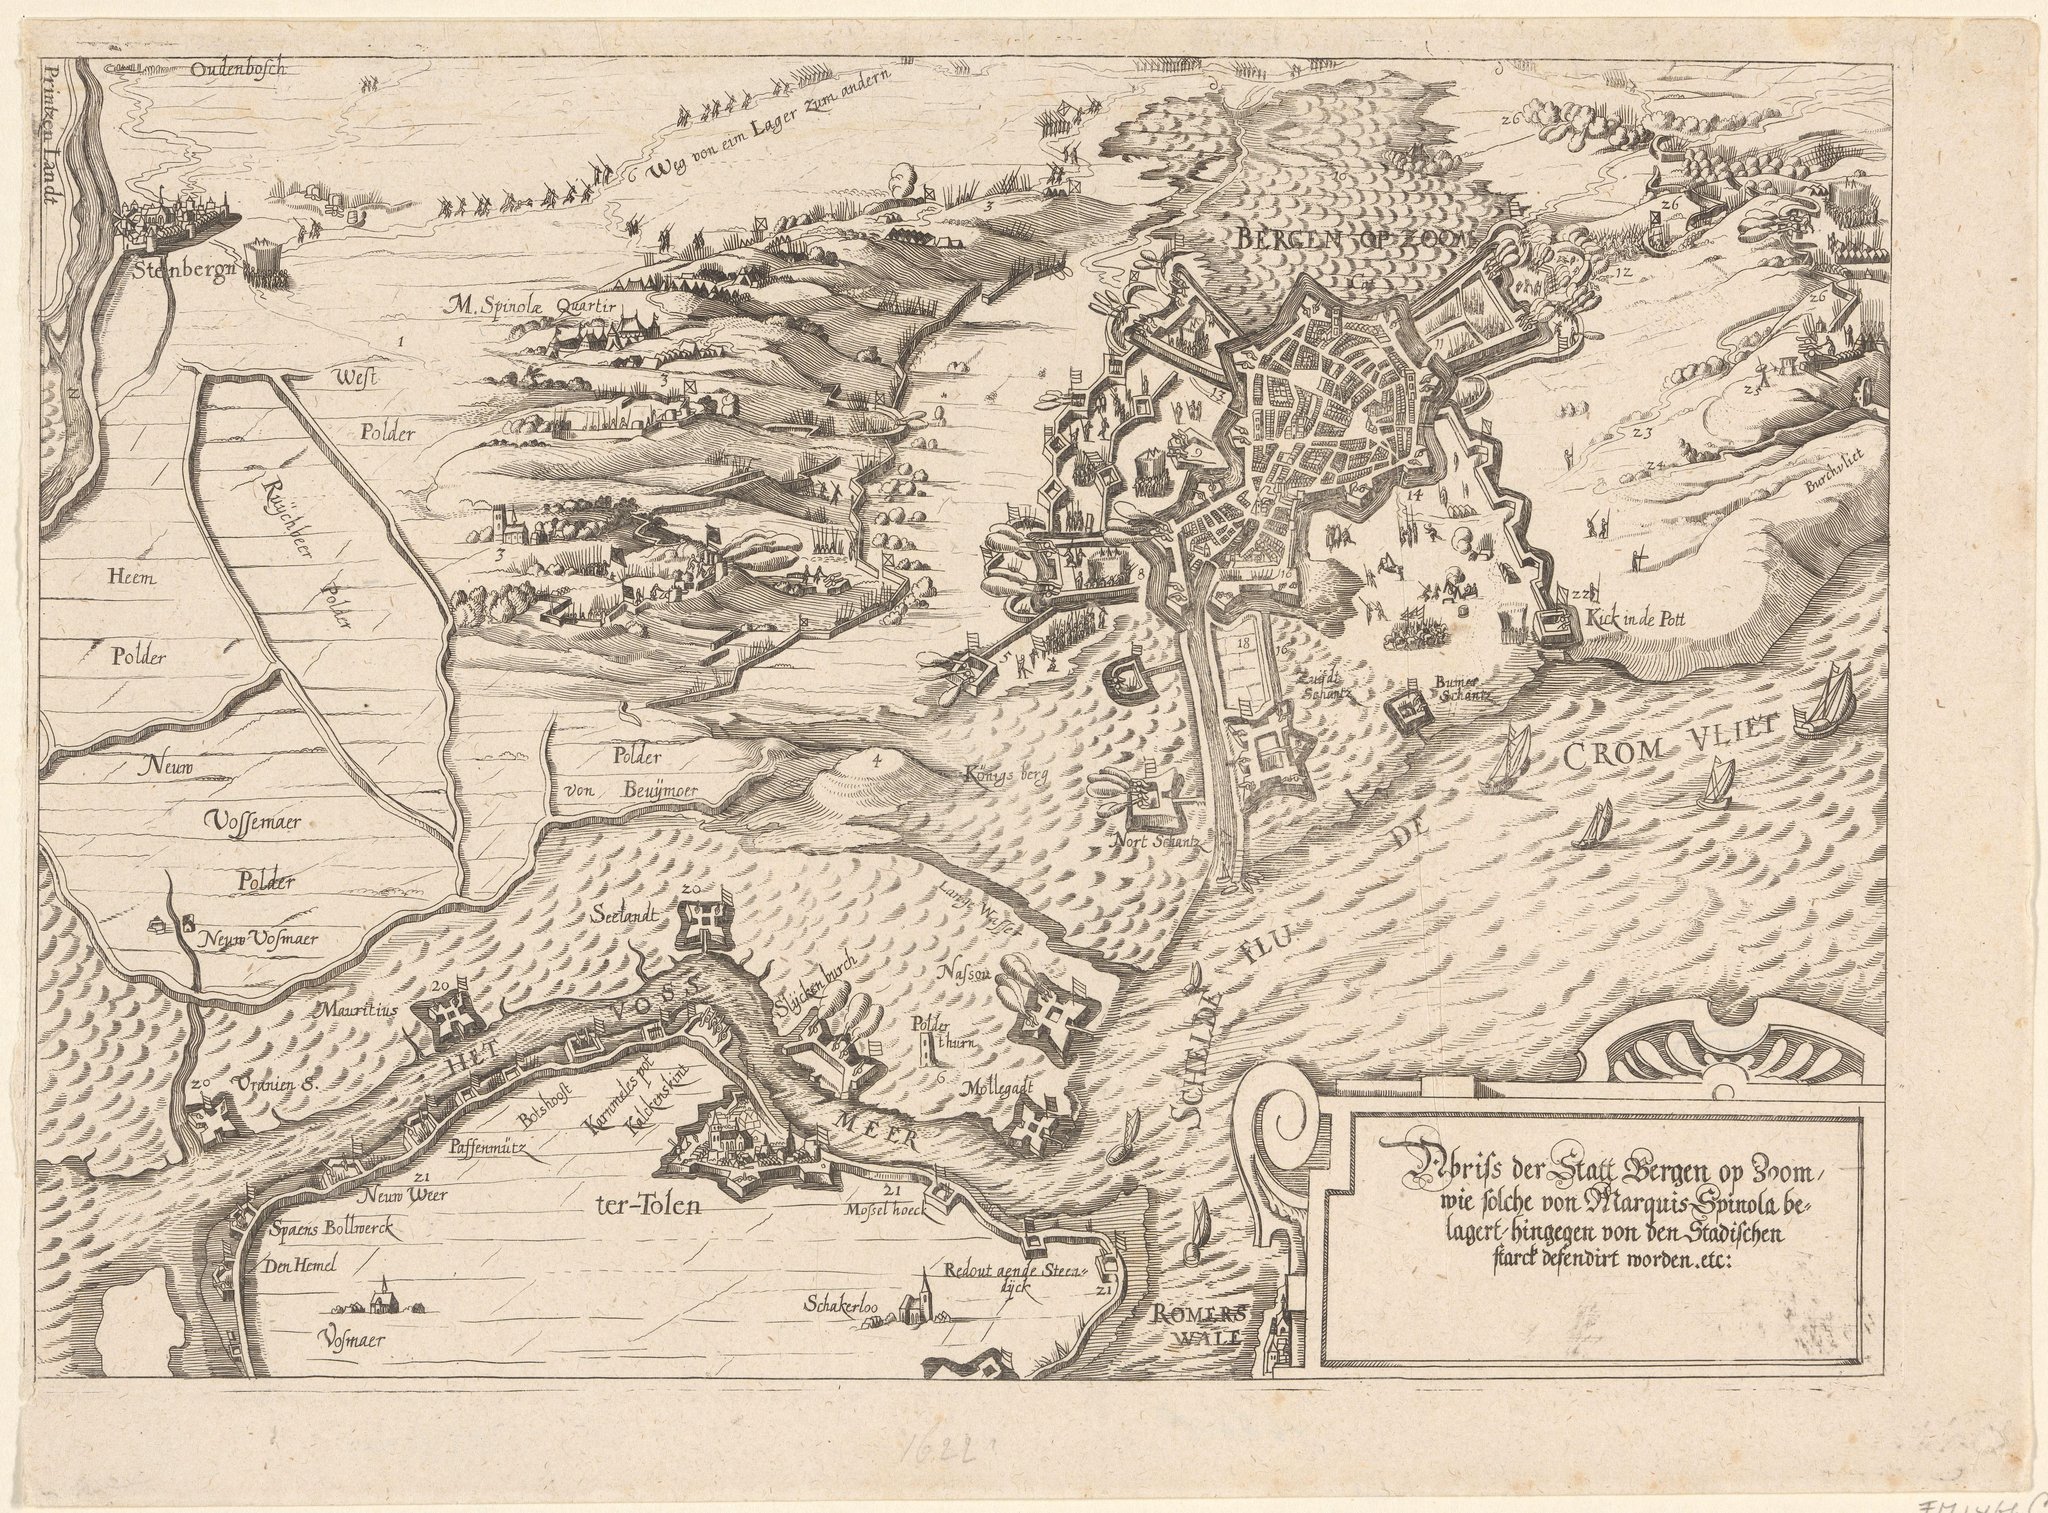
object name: print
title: Beleg van Bergen op Zoom, 1622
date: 1622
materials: paper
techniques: etching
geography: germany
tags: siege, position war, bergen op zoom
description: Mislukt beleg van Bergen op Zoom door het Spaanse leger onder Spinola en Velasco, 18 juli - 3 oktober 1622. Plan van de stad en omgeving met waterwegen. Rechtsonder een cartouche met de titel. Details in de voorstelling genummerd, maar de legenda ontbreekt.